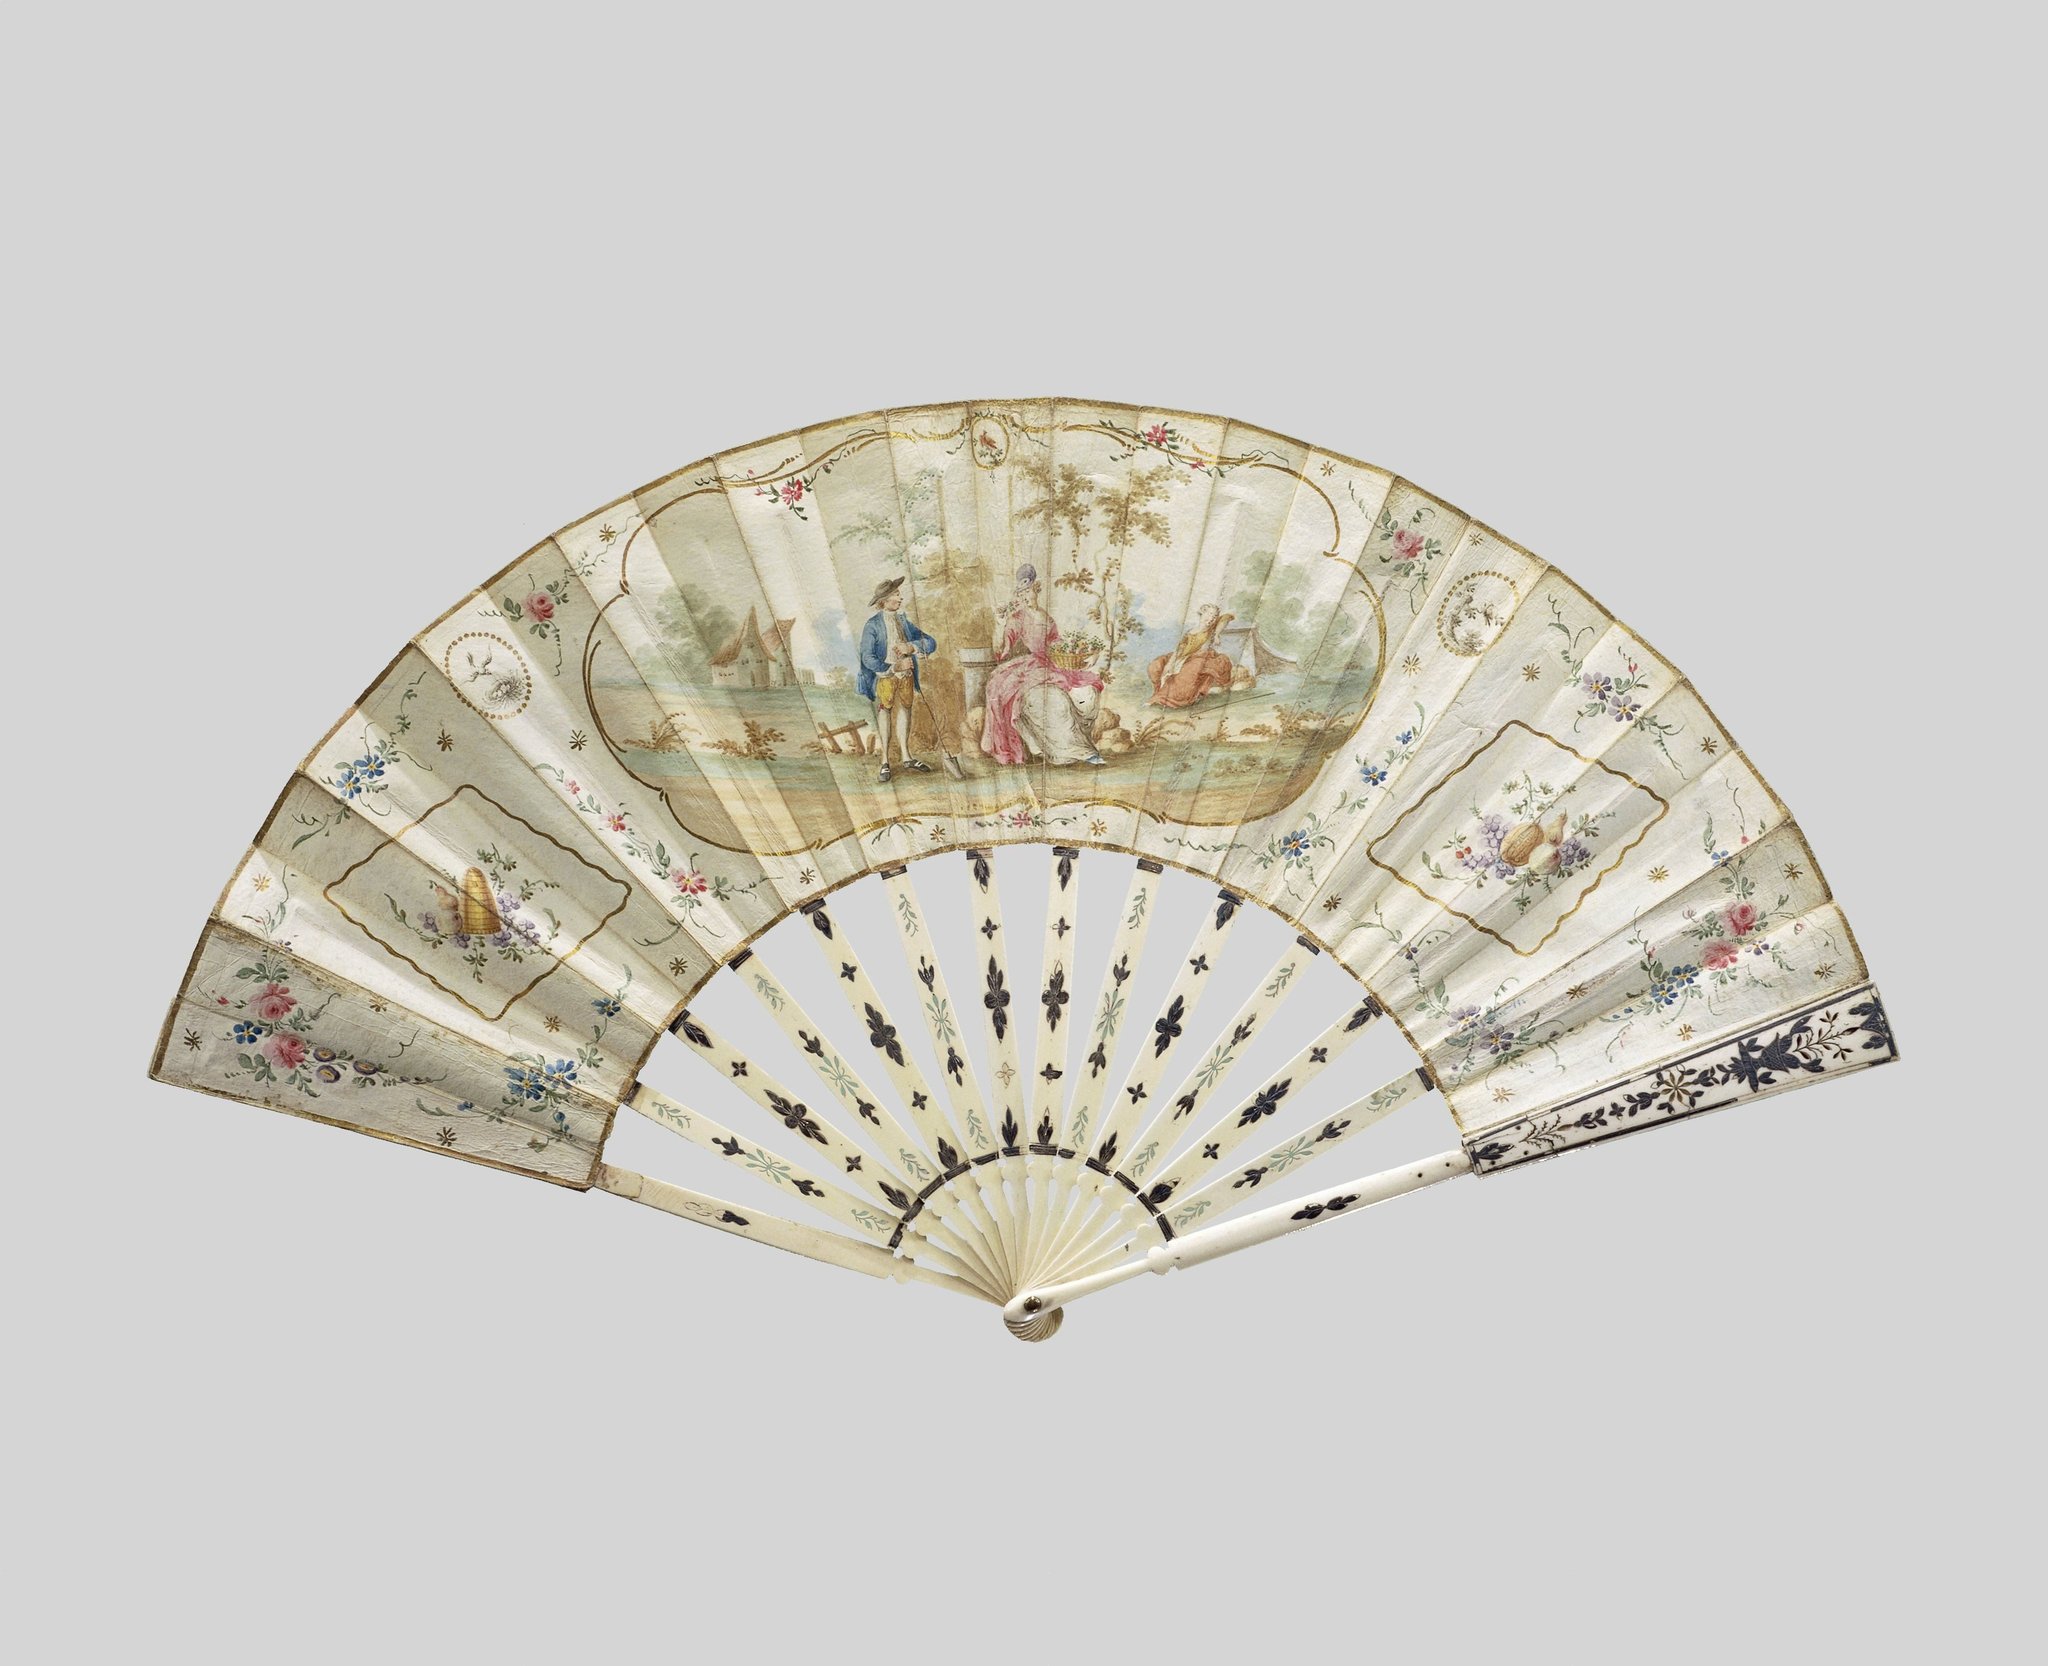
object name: vouwwaaier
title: Vouwwaaier met een blad van papier (?) waarop in aquarel een cartouche met pastorale voorstelling, op een montuur van in reliëf gesneden ivoor voorzien van bladzilver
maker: Anonymous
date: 1780-1795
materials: ivory, paint, paper, silver leaf, watercolor, wood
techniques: cutting, inlay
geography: netherlands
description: Op een pastorale waaier uit het vierde kwart van de 18 eeuw in de verzameling van het Kostuummuseum in Den Haag (inv. KT28-1973), is links op de achtergrond precies hetzelfde huisje met extreem puntig dak zichtbaar als op de centrale scene van deze waaier. Ook het kleine ovale medaillon rechts, met het vogeltje op een tak, is op beide waaiers gelijk. Het meest opvallend is echter, dat het slapende vrouwtje dat rechts van het verliefde paar tegen een muur aan leunt, op beide waaiers op dezelfde plaats en in dezelfde houding is afgebeeld. Alleen haar kleding verschilt: op de waaier in Den Haag draagt zij een japon met een open rok, waraonder een rok in een andere kleur zichtbaar is. Er zijn verschillende verklaringen voor deze overeenkomsten mogelijk: er kan naar hetzelfde voorbeeld zijn gewerkt, dan wel de waaierbladen kunnen door dezelfde hand of in hetzelfde atelier zijn geschilderd. Aangezien de overeenkomsten hier juist in het bijwerk optreden, lijkt het waarschijnlijk dat beide waaierbladen door dezelfde hand zijn geschilderd. In het kleine ovale medaillon links keert een vogeltje terug naar een nest vol eitjes. Het lijkt een duidelijke zinspeling, maar in het pendant zit een vogeltje alleen op een tak. De betekenis van deze combinatie is niet geheel duidelijk. In de ruiten links en rechts allerlei vruchten zoals druiven, peren, appelen, kersen en zelfs een watermeloen. Verder ook een bijenkorf, die onmisbaar is bij de fruitteelt. Het motief van de vruchtenschaal op de buitenbenen sluit hierbij aan.